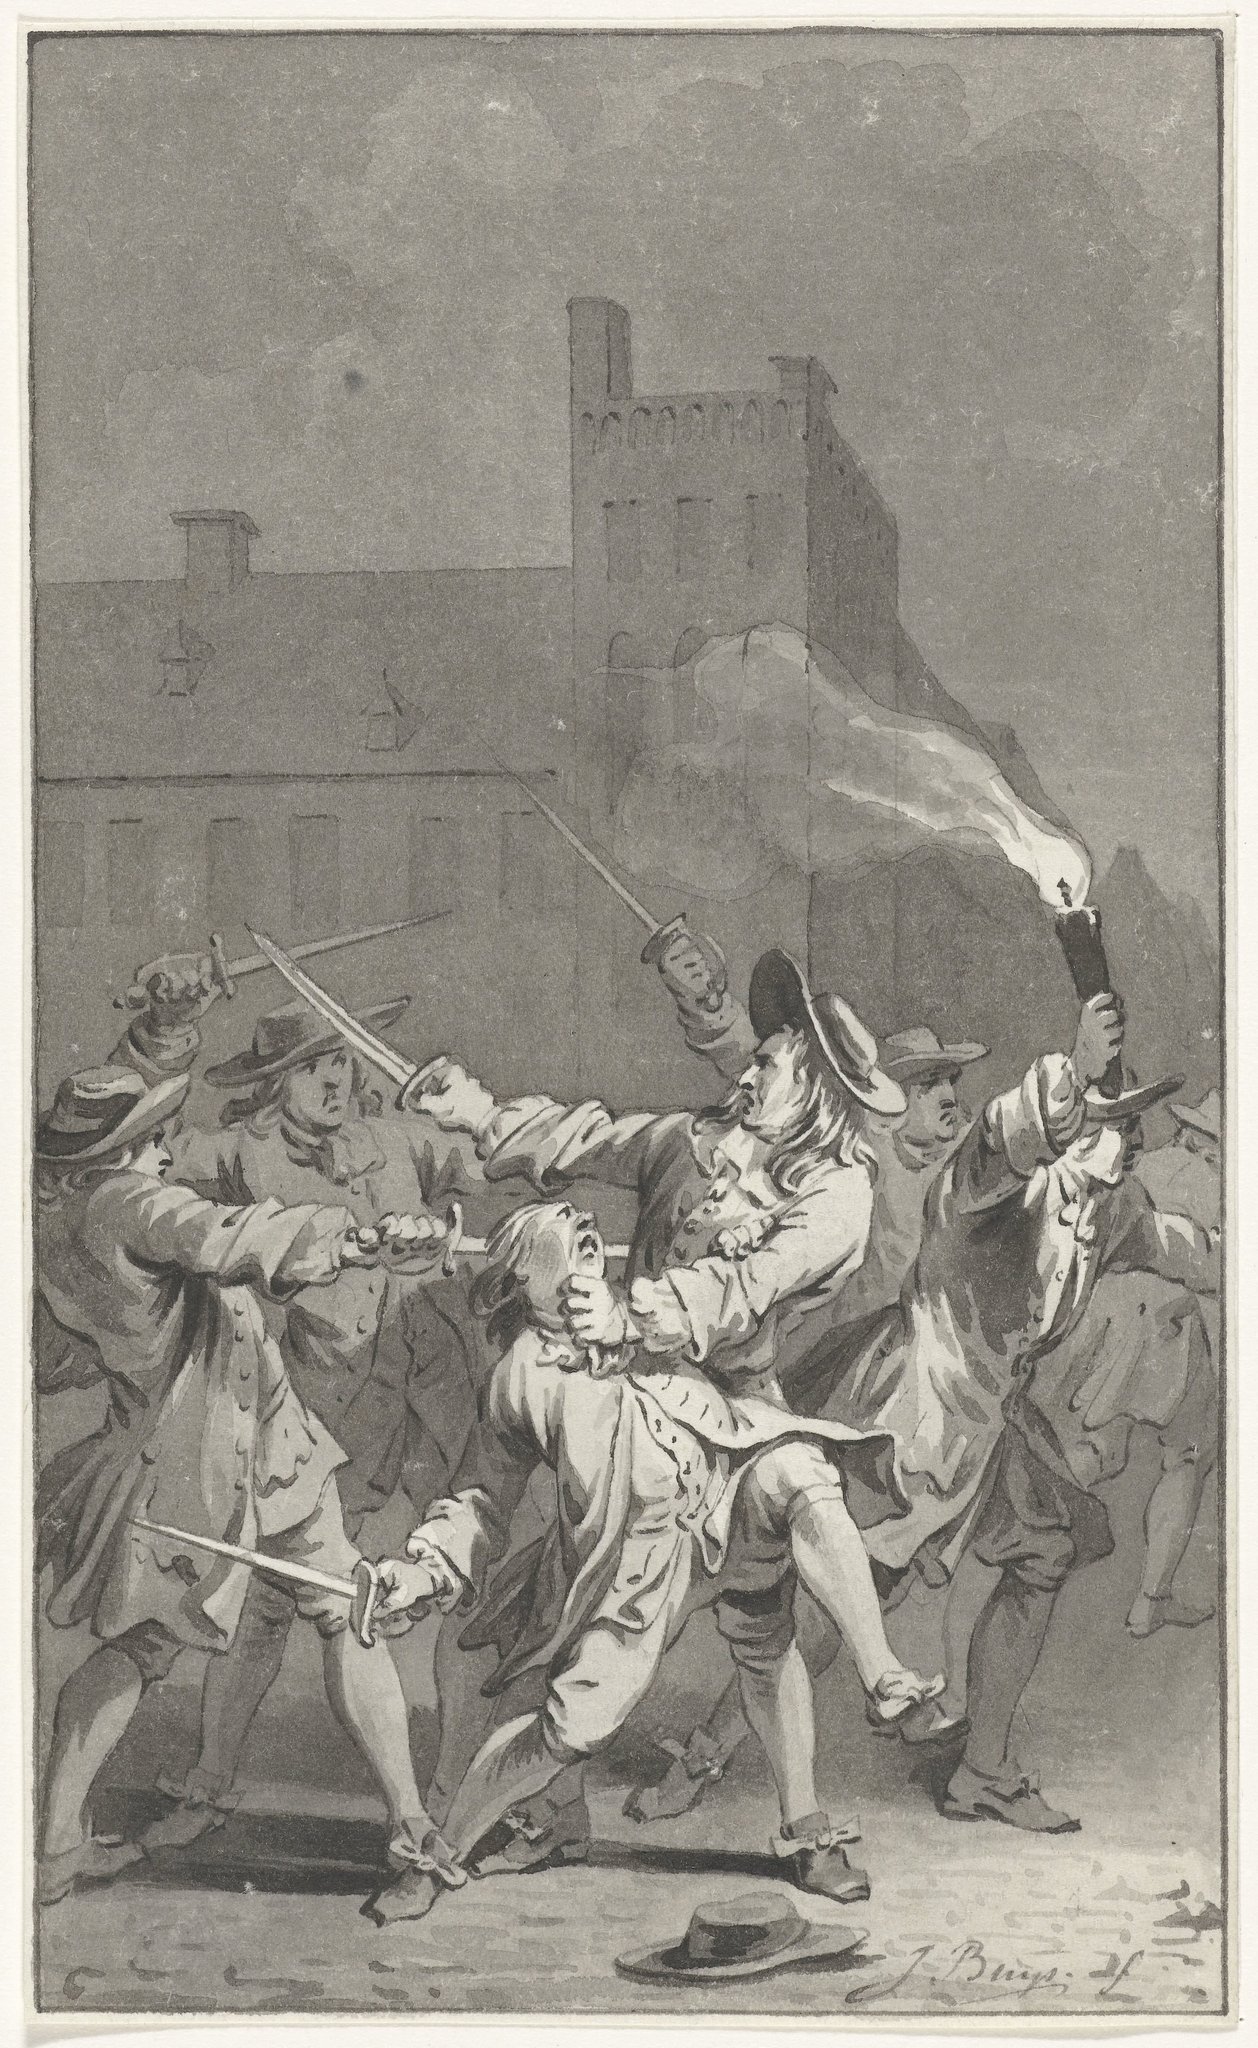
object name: drawing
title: Johan de Witt aangevallen en zwaar gewond, 1672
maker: jacobus buys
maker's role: draughtsman, print maker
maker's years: 1724-1801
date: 1788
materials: ink, paper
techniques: brush, pen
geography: northern netherlands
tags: the hague, politician, johan de witt, attempt, political murder, fighting, rampjaar (disaster year)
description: Raadpensionaris Johan de Witt wordt op straat aangevallen door een groep gewapende mannen onder leiding van Jacob de Graef en raakt zwaar gewond, juni 1672